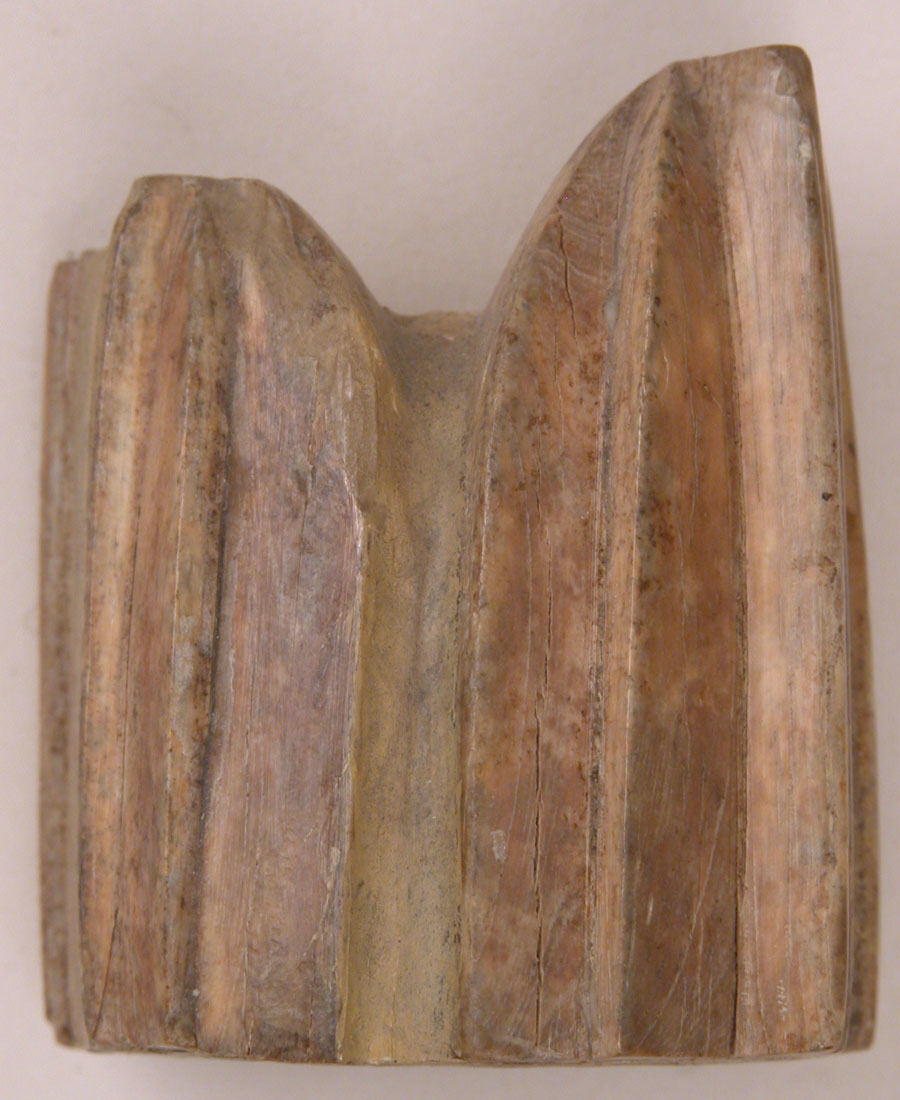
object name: chess piece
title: Chess Piece, King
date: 701-1000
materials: ivory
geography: western islamic lands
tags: chess